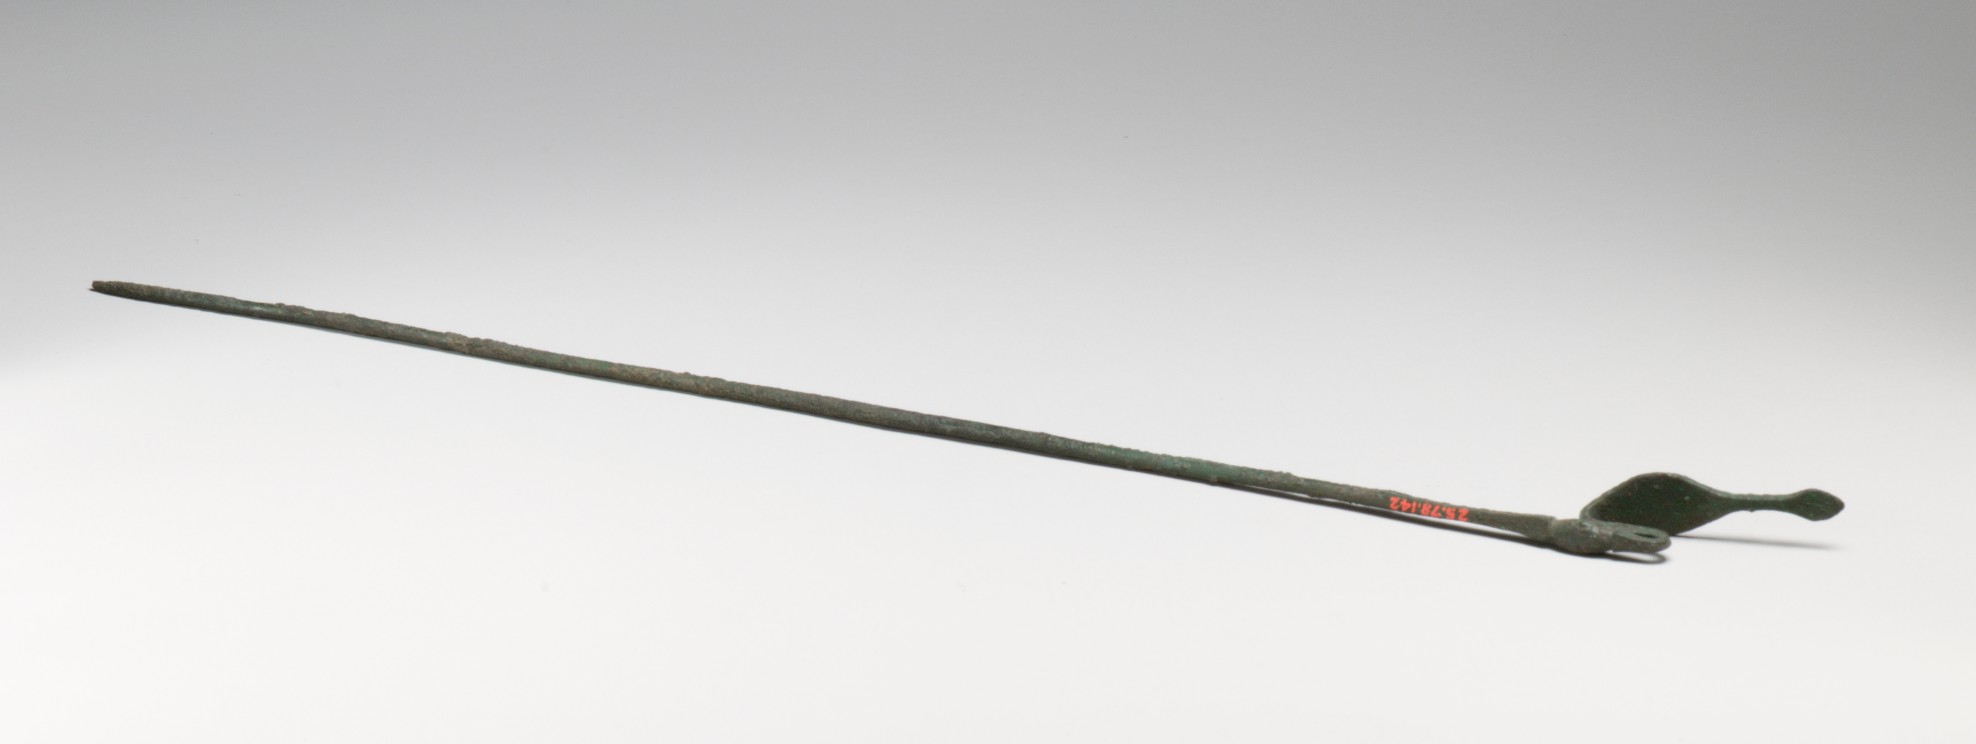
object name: pin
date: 7000 BCE-330 CE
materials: bronze